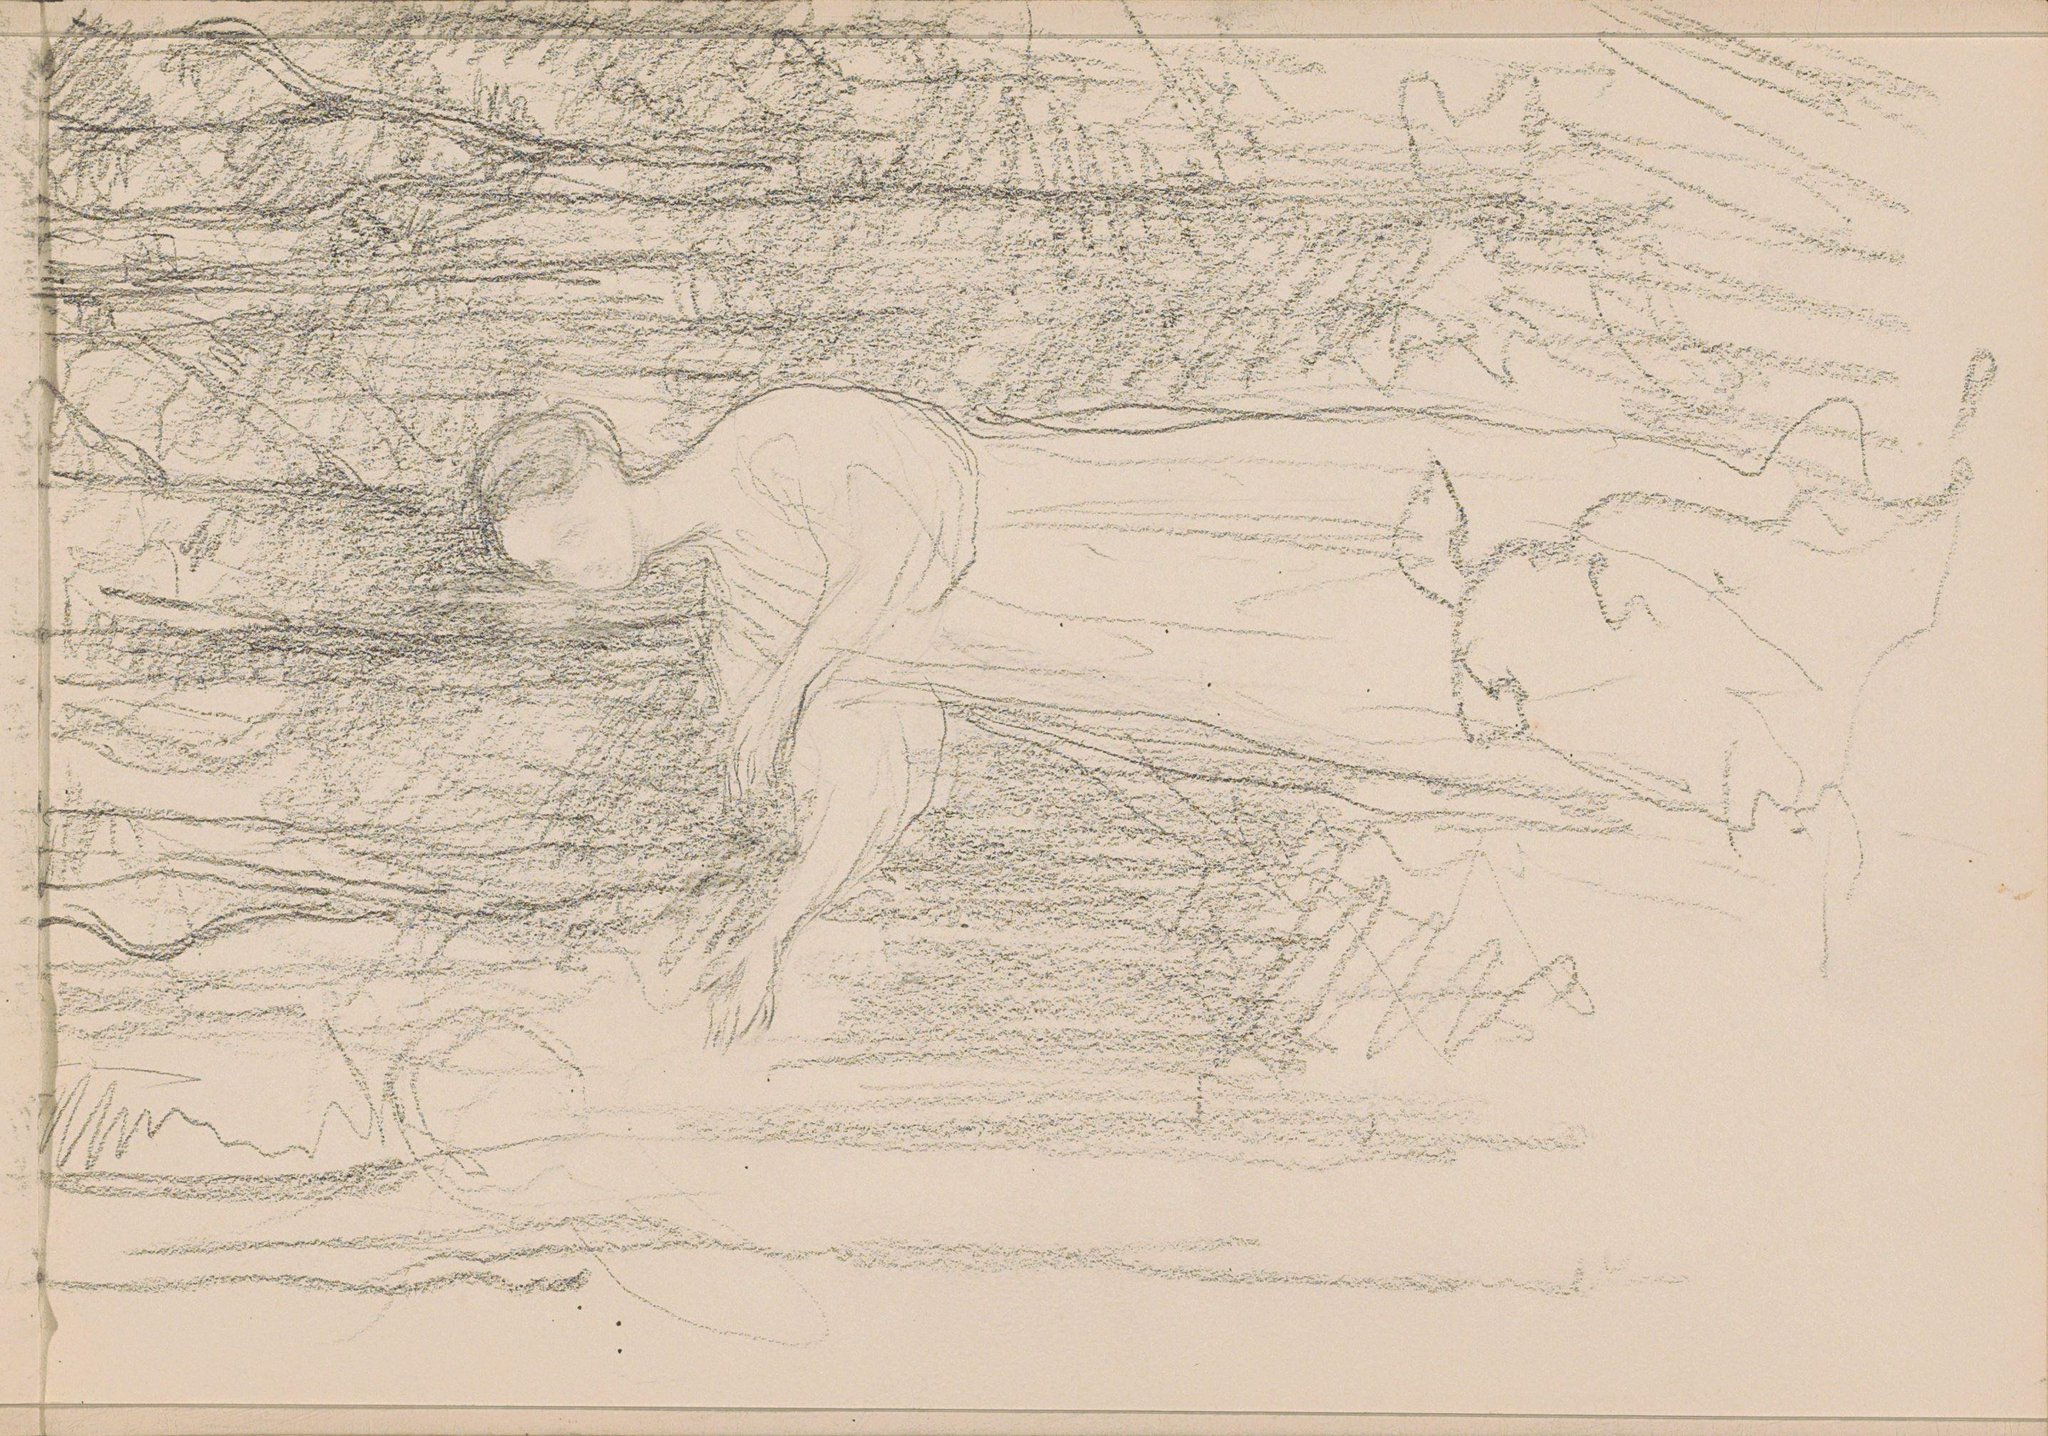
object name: sketchbook leaf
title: Vrouw met opgeheven armen in een bos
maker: a.a.l. de grammont-hubrecht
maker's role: draughtsman, painter, print maker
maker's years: 1855-1913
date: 1865-1913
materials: chalk, paper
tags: arm raised upward, adult woman, forest, wood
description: Blad 23 recto uit een schetsboek met 68 bladen.